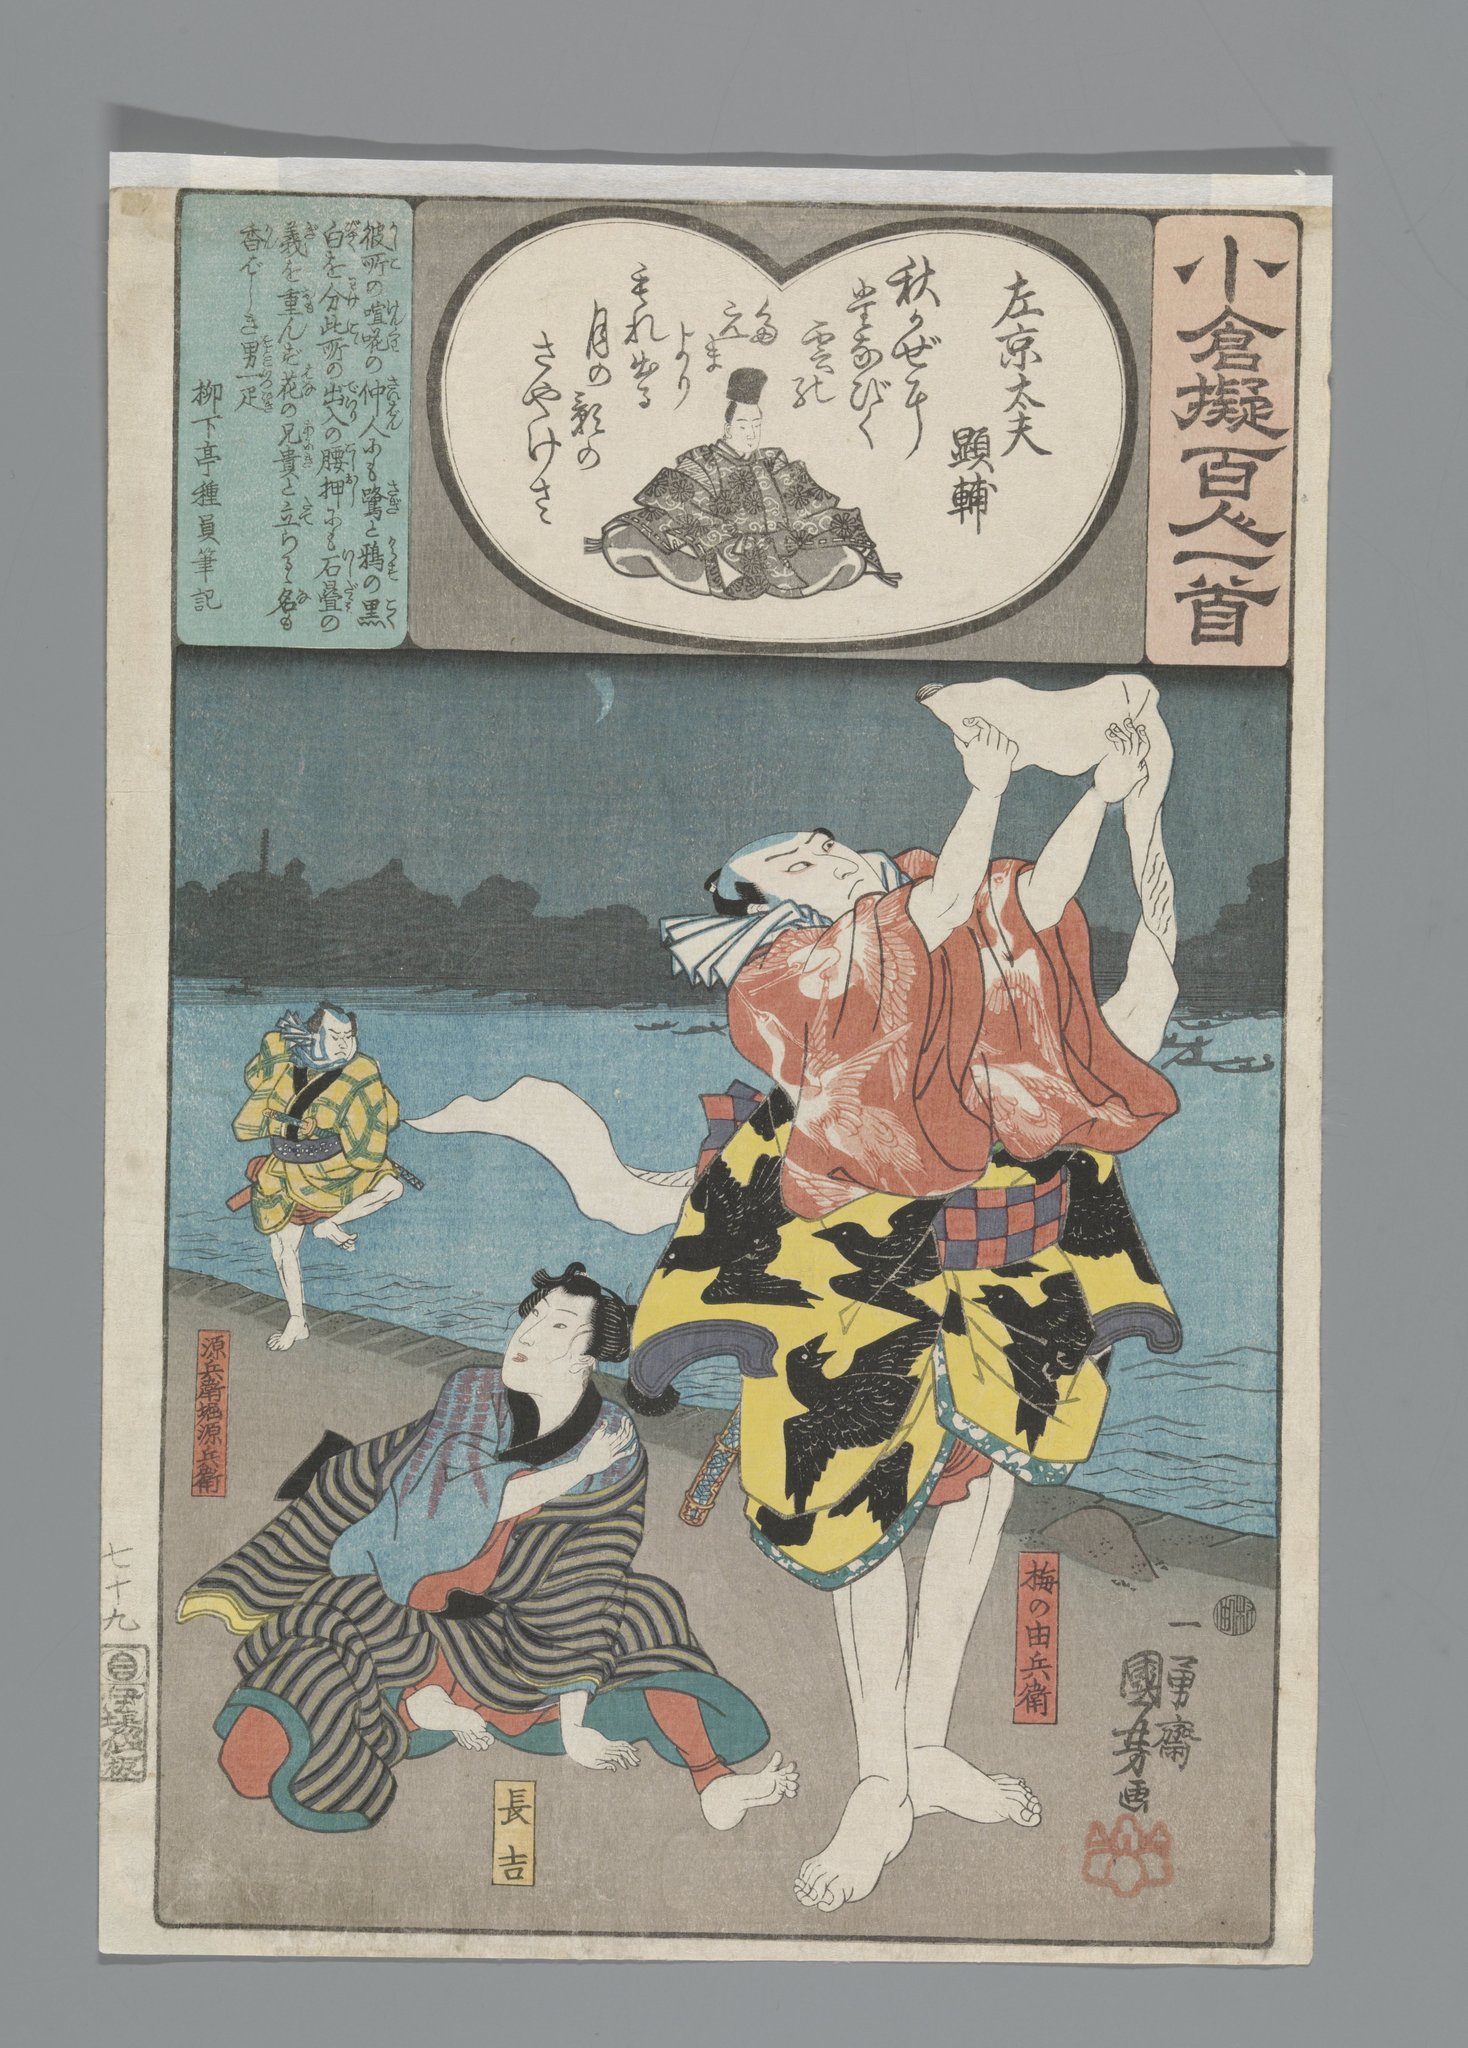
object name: print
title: Ogura Imitation of the One Hundred Poems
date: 1846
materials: paper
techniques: woodcut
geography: japan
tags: adult man (+ three persons), moonlight, lover with love-letter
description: Yoshibei leest een liefdesbrief bij het licht van de maan. Zijn jongere zwager zit gewond op de grond en kijkt om naar de oplichter Gengobei, die in de verte aan komt rennen. Scene uit een kabukitoneelstuk. Gedicht door Sakyô no Daibu Akisuke.